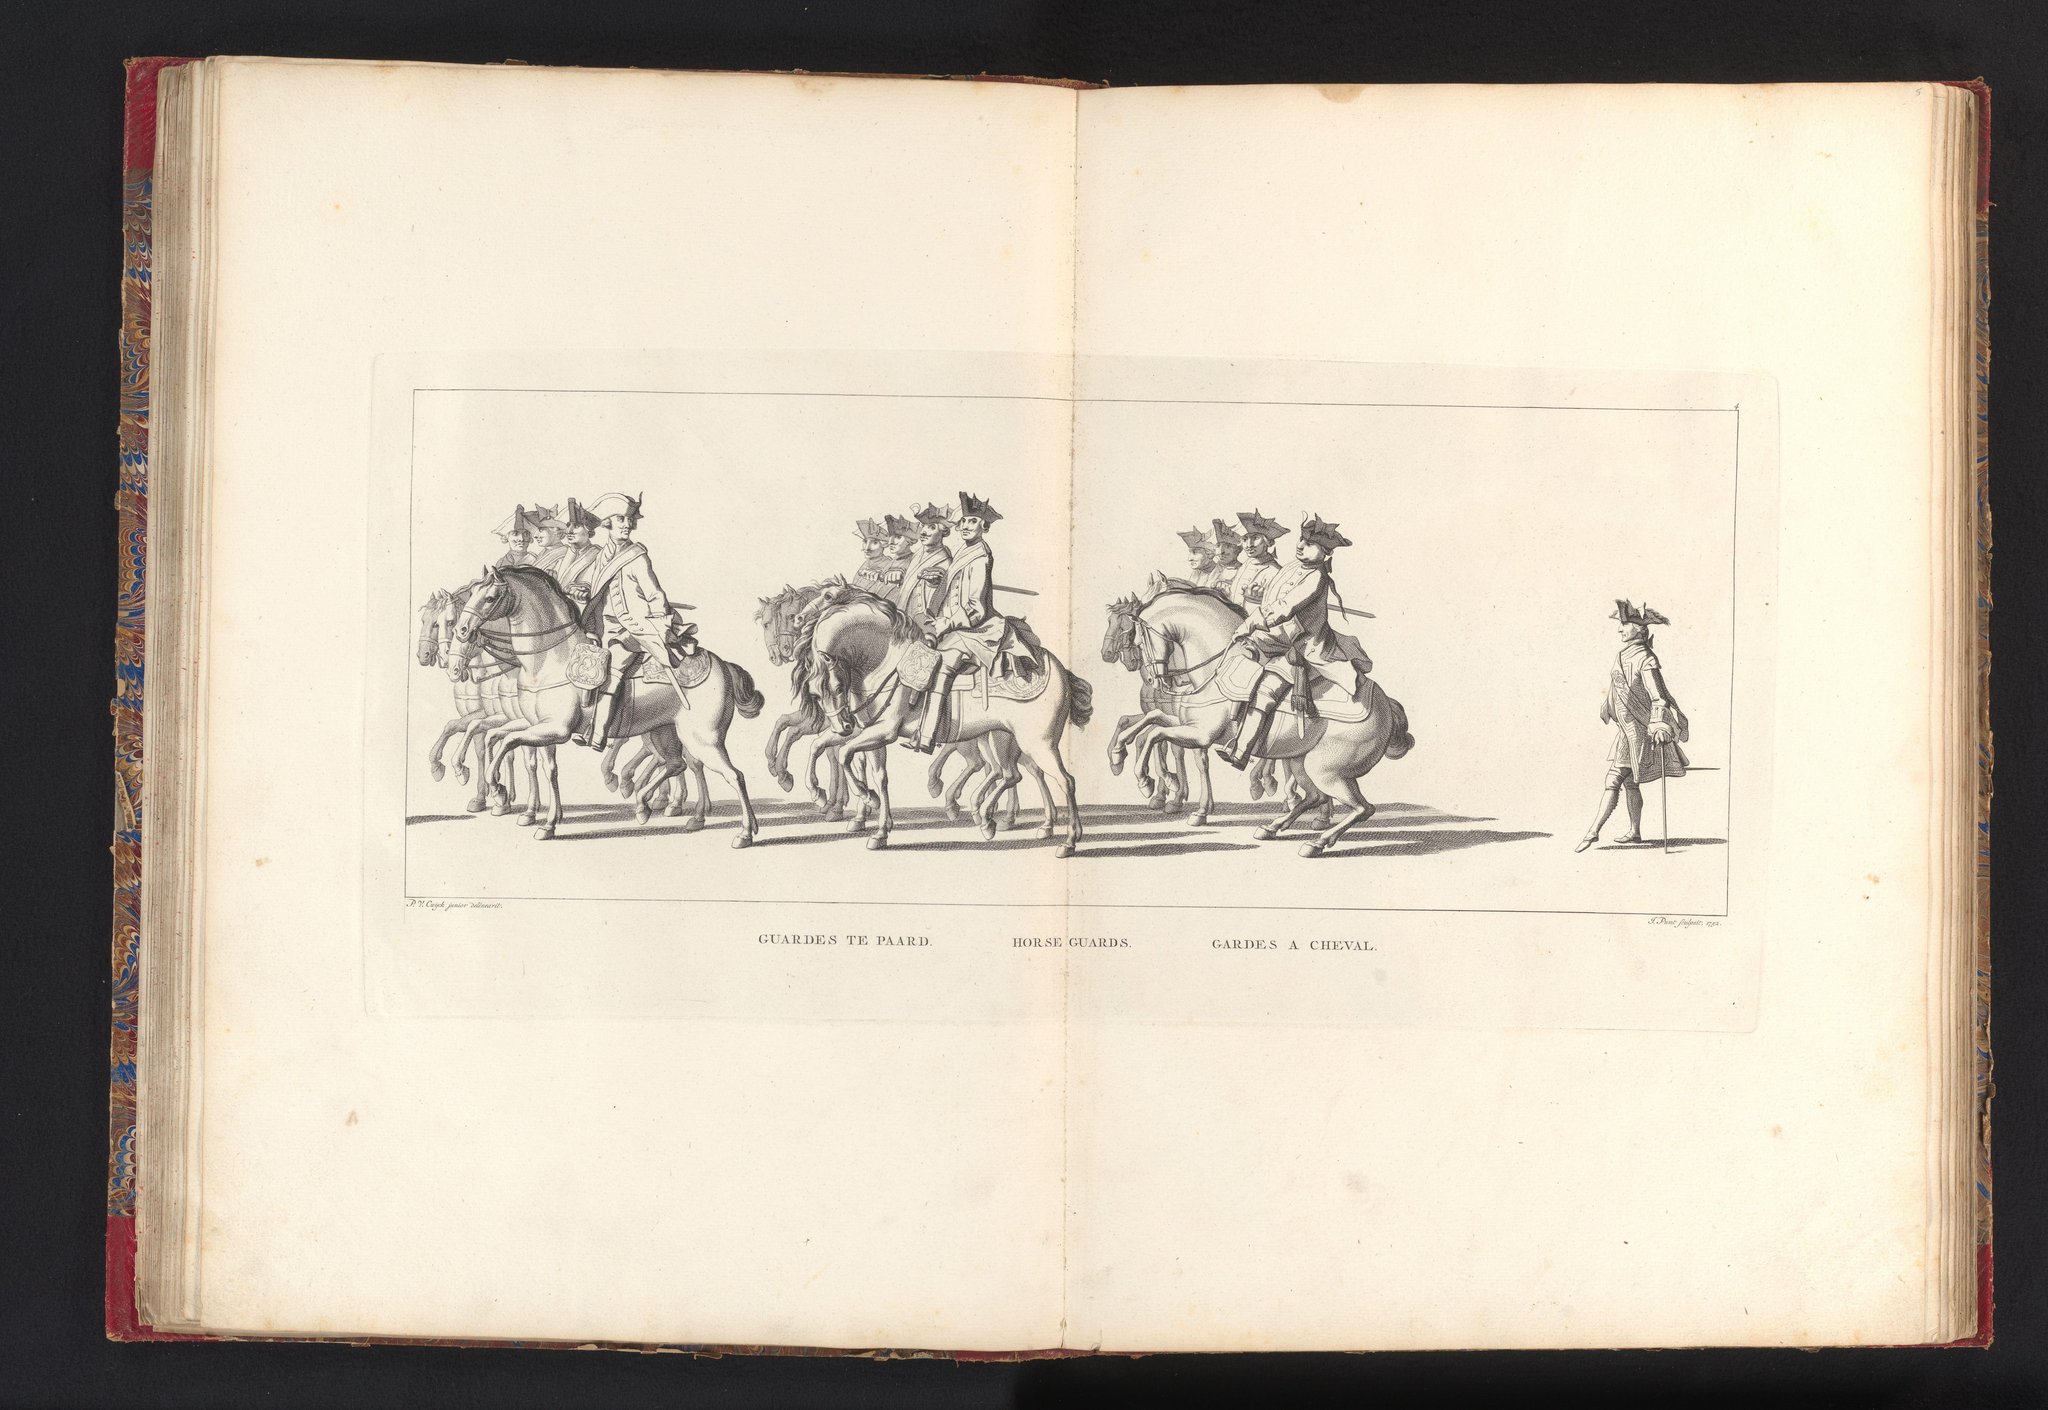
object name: album leaf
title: Guardes te paard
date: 1752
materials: paper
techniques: engraving, etching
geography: the hague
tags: the hague, willem iv (prins van oranje-nassau), military parade, pageant (+ infantry), cortege, funeral procession, delft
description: Drie groepen gardes te paard. In de marge een onderschrift in het Nederlands, Frans en Engels. De prent maakt deel uit van een album.